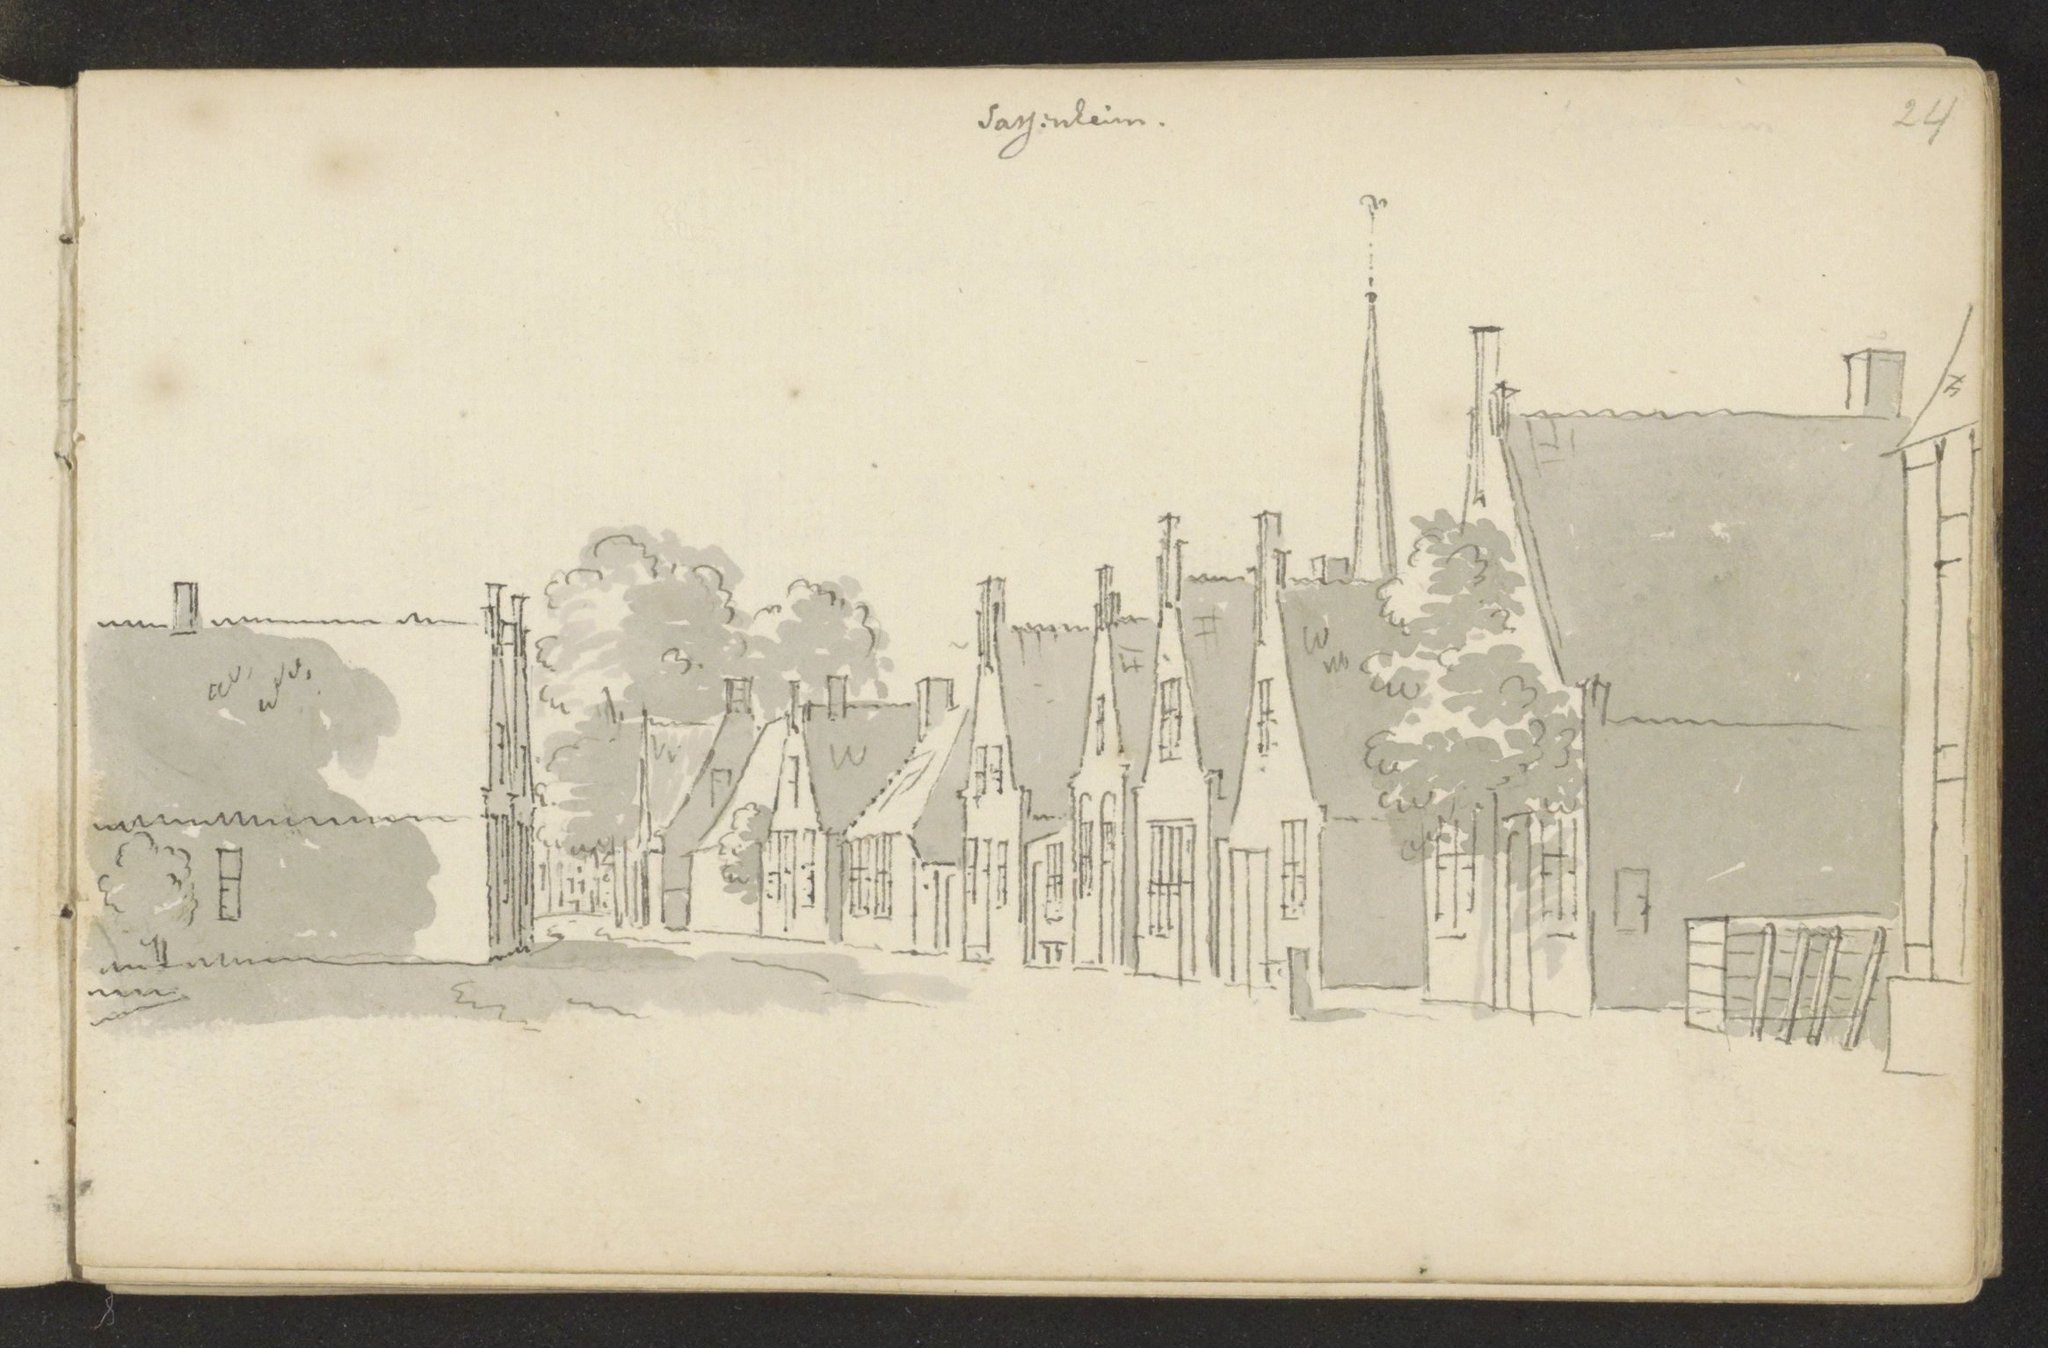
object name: sketchbook leaf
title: Dorpsgezicht te Sassenheim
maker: abraham de haen (ii)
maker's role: draughtsman, print maker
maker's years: 1707-1748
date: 1731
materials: ink, paper, pencil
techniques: brush, pen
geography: sassenheim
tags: public road in village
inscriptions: annotation: ‘Sassenheim’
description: Blad 24 recto uit een schetsboek met 78 bladen.